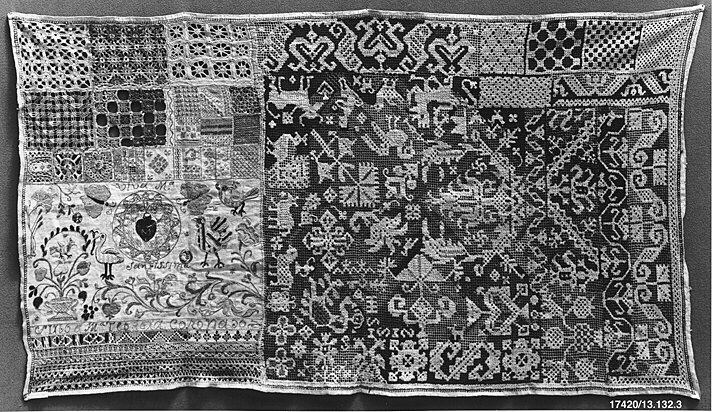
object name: sampler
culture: mexican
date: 1766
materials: canvas, silk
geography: spain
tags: birds,flowers